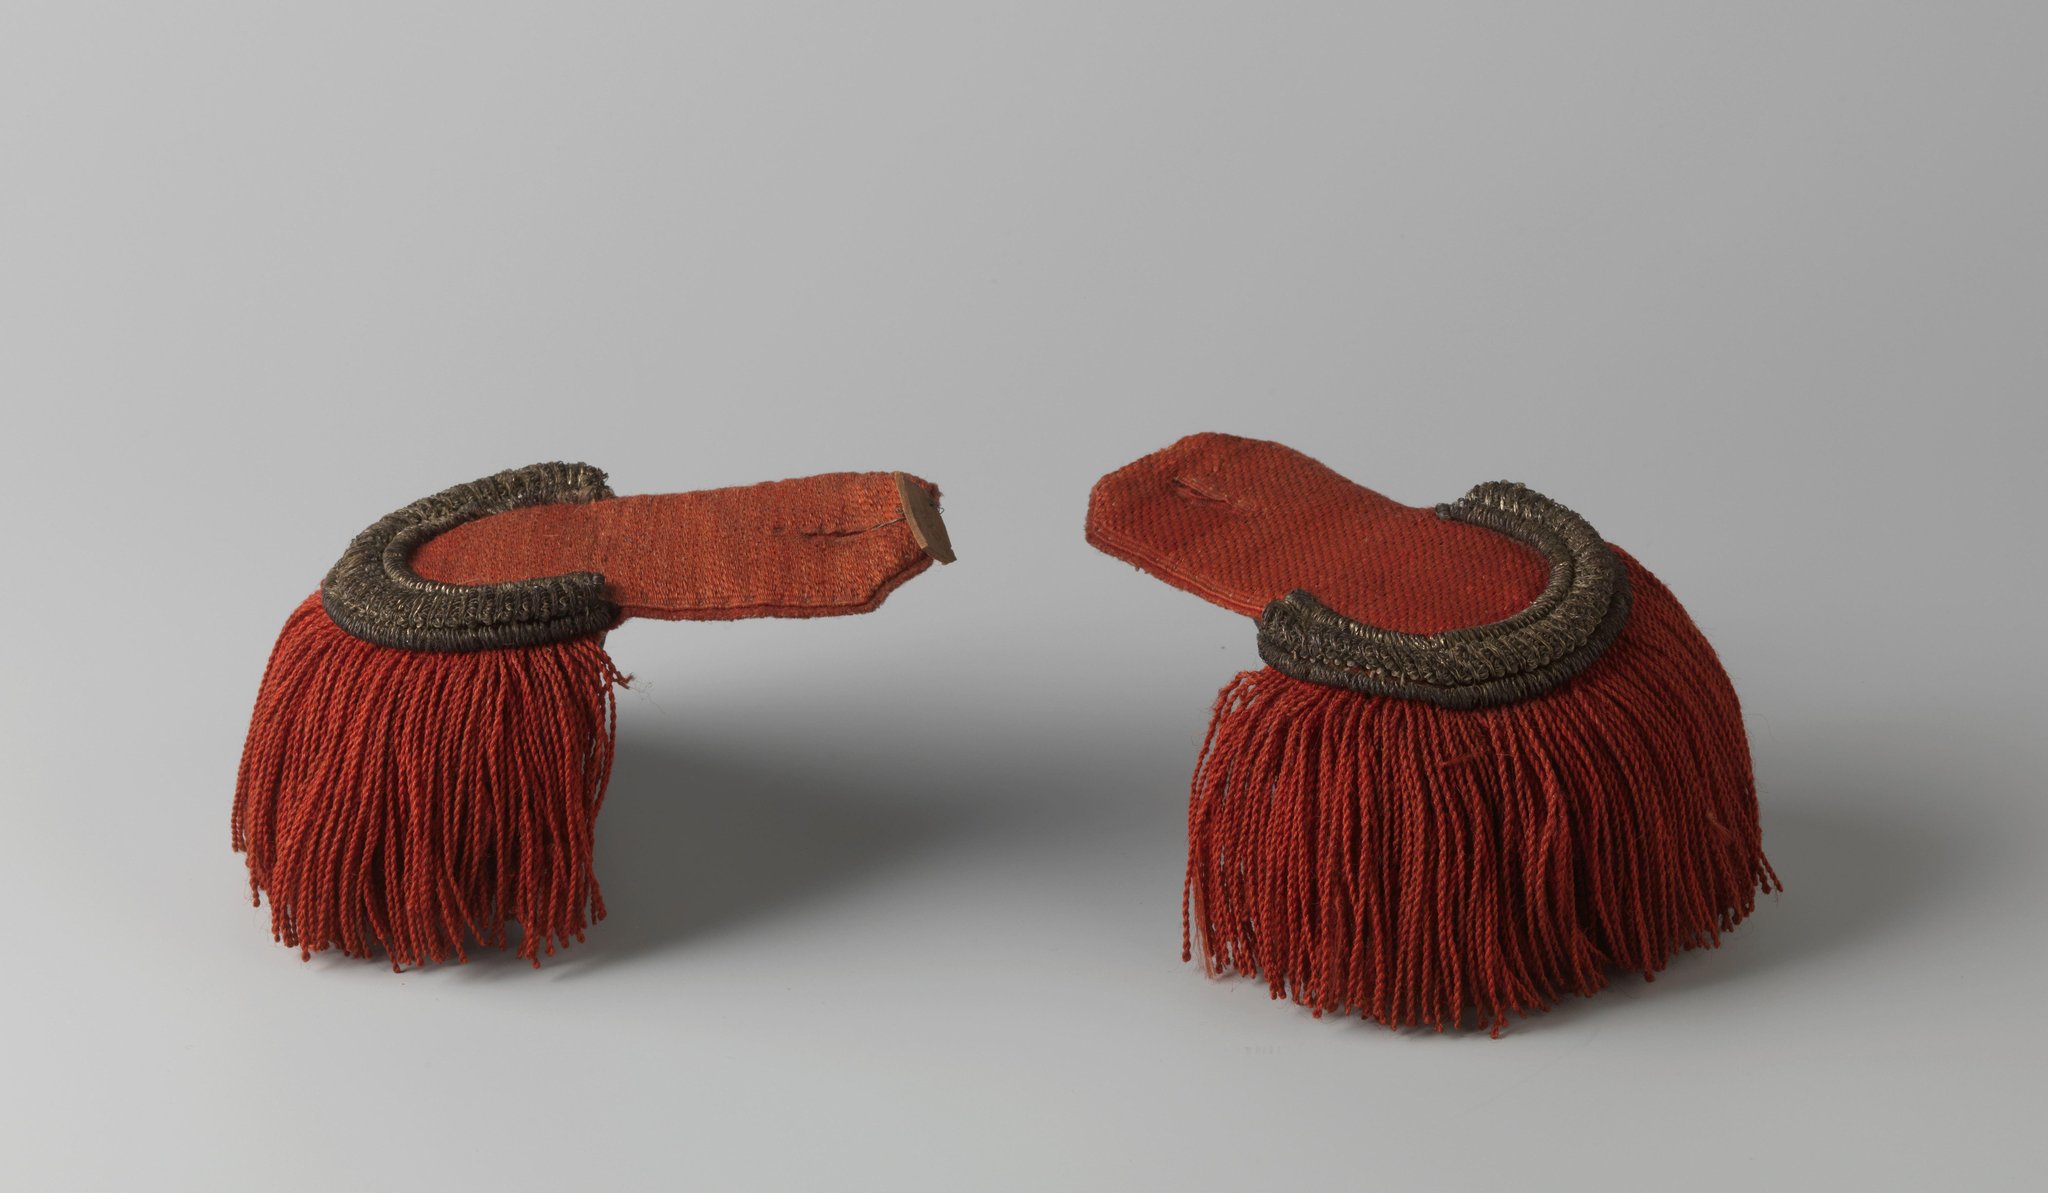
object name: epaulet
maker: Anonymous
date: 1800-1830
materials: thread, wool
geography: netherlands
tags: belgium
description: Epaulet van rode wol, versierd met zilvergalon en torsades.